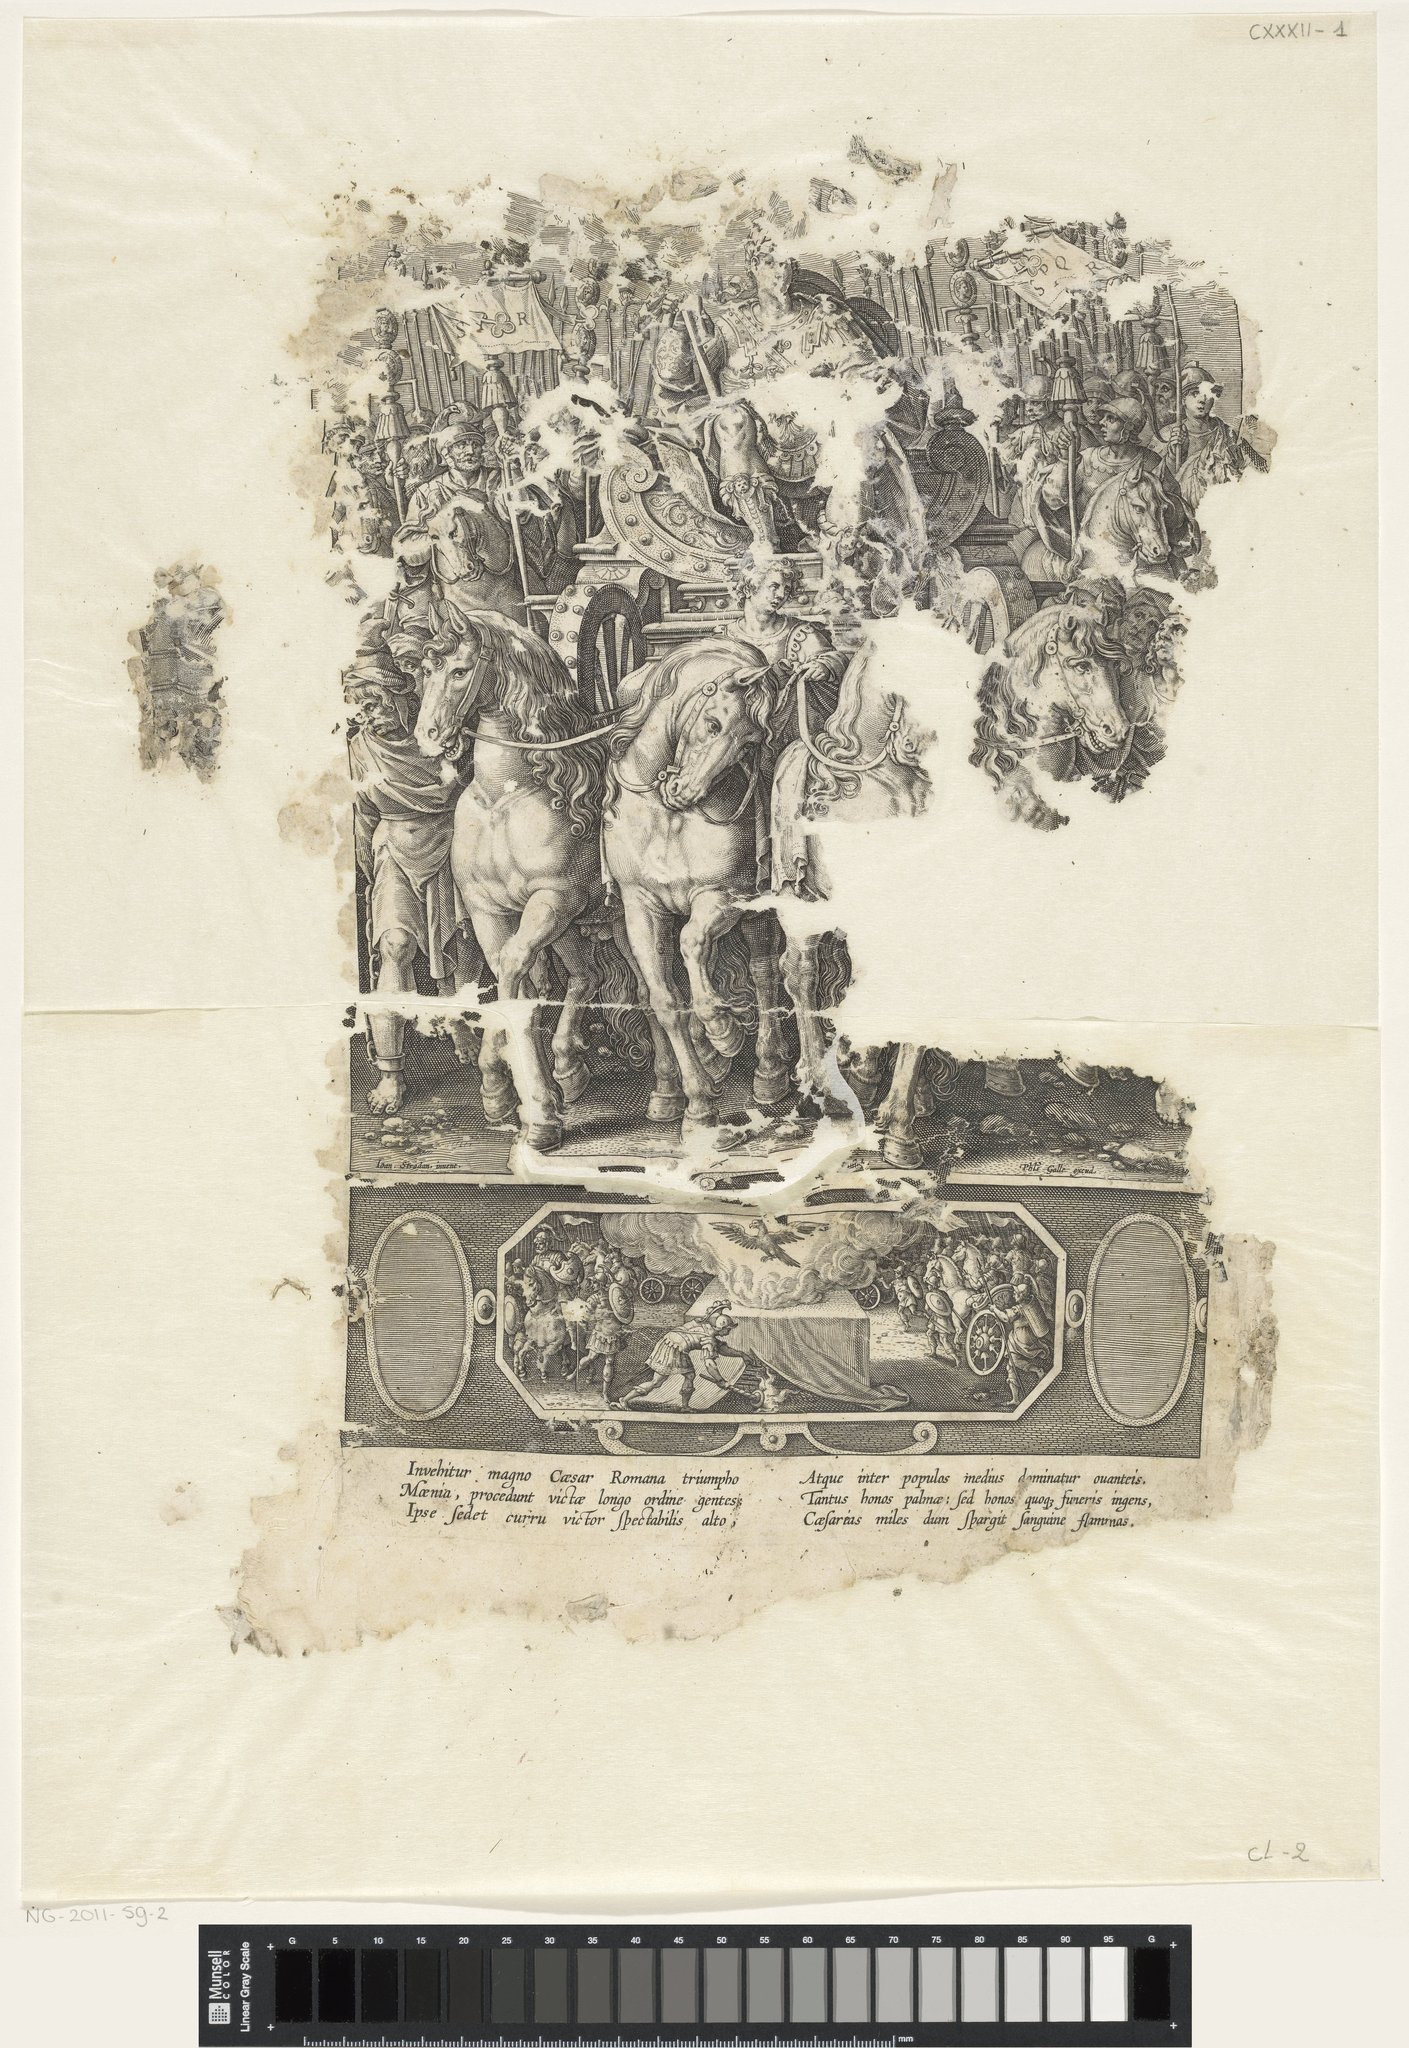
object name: print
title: Imperatorum XII a Suetonio descriptorum effigies resque gestae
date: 1587-1589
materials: paper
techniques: engraving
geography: antwerp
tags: triumph of caesar (+ in allegorical or symbolic frame or setting; with allegorical or symbolic accessories)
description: De prenten in de Nova Zembla collectie zijn tijdens een expeditie van Willem Barendsz en Jacob van Heemskerk in 1596-1597 noodgedwongen in het winterkamp, het ‘Behouden Huis’, op het eiland achtergelaten. De prenten waren in één of meerdere stapels als handelswaar meegenomen vanuit Amsterdam. Bijna drie eeuwen later, in 1871, keerde de Noor Elling Carlsen terug naar Nova Zembla en vond daar de restanten van het ‘Behouden Huis, inclusief een groot deel van de inventaris. Een deel van de prenten, in de vorm van aaneengekoekte kluiten, werd toen ook teruggevonden. De papierkluiten waren soms op meerdere plekken gebroken. Tussen 1975-1979 zijn de prenten van elkaar gescheiden. Dit leverde in totaal ca. 1000 fragmenten van ca. 400 afdrukken van ca. 150 verschillende prenten op. Voor zover mogelijk zijn de fragmenten samengevoegd en zijn de prenten gereconstrueerd.